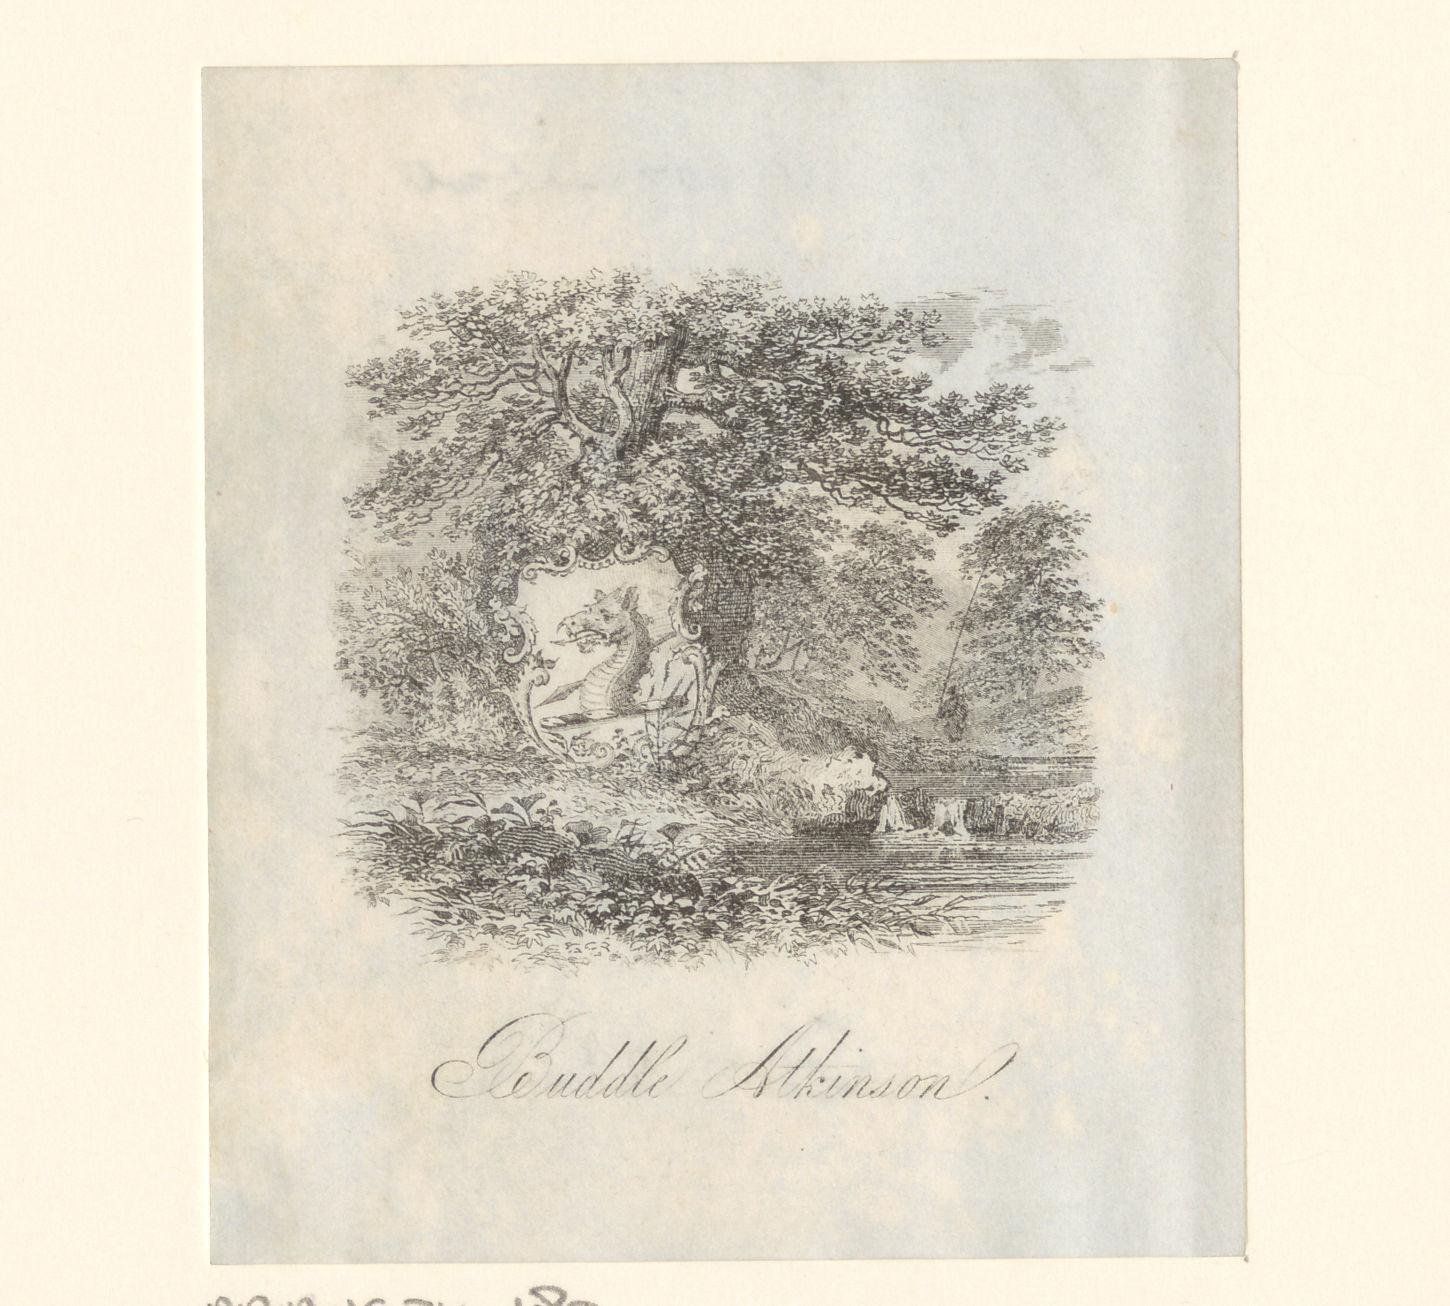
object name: print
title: Ex libris van Buddle Atkinson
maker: thomas bewick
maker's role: draughtsman, painter, print maker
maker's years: 1753-1828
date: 1768-1828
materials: paper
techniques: engraving, etching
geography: great britain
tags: trees, armorial bearing, heraldry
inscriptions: collector's mark: Lugt 2228